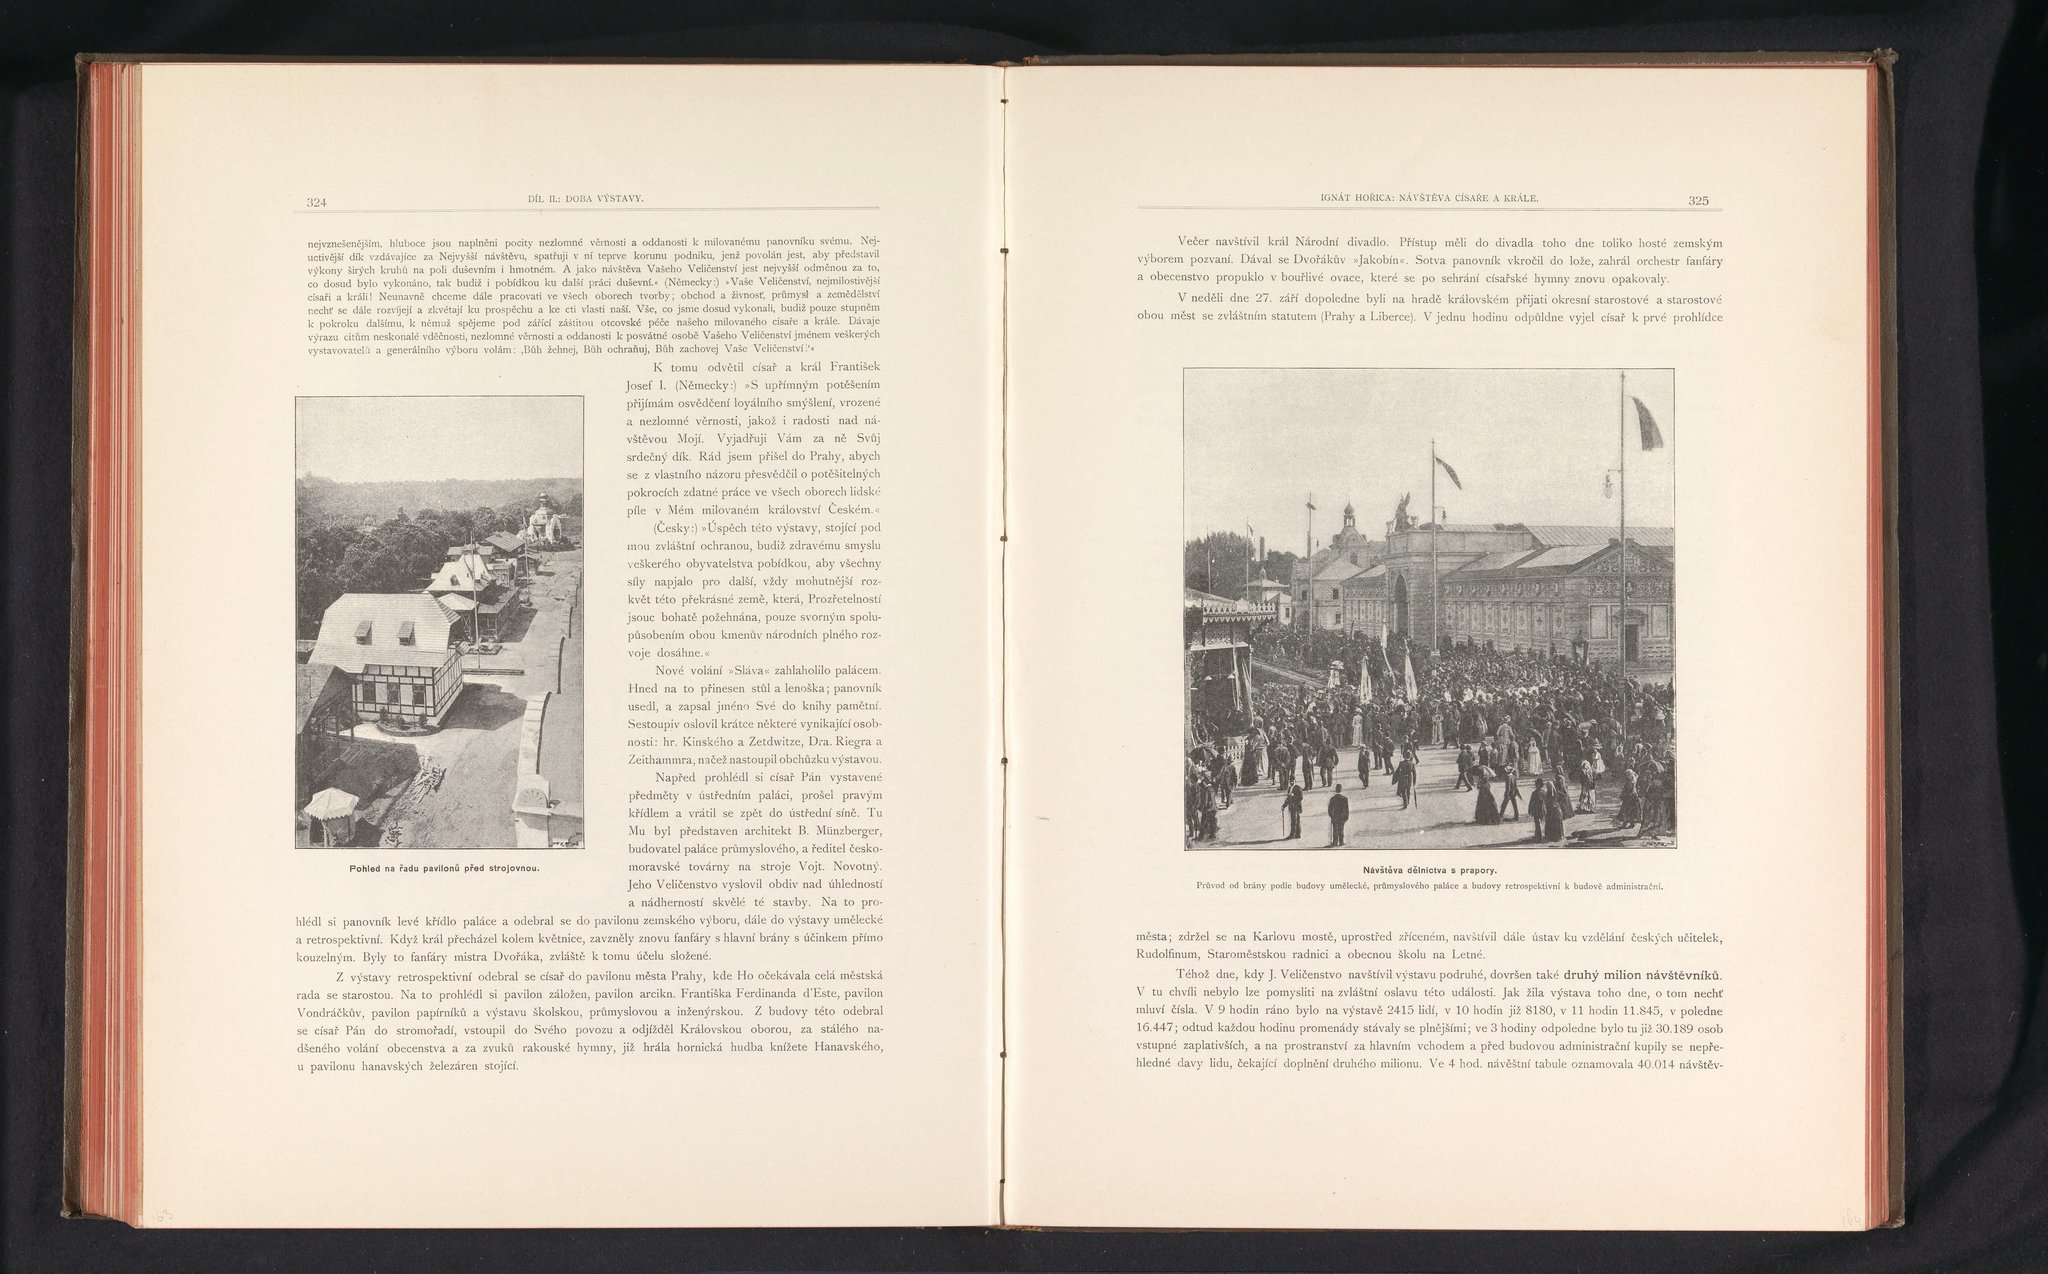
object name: page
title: Gezicht op paviljoens te Praag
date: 1891-1893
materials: paper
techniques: autotype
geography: prague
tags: façade (of house or building)